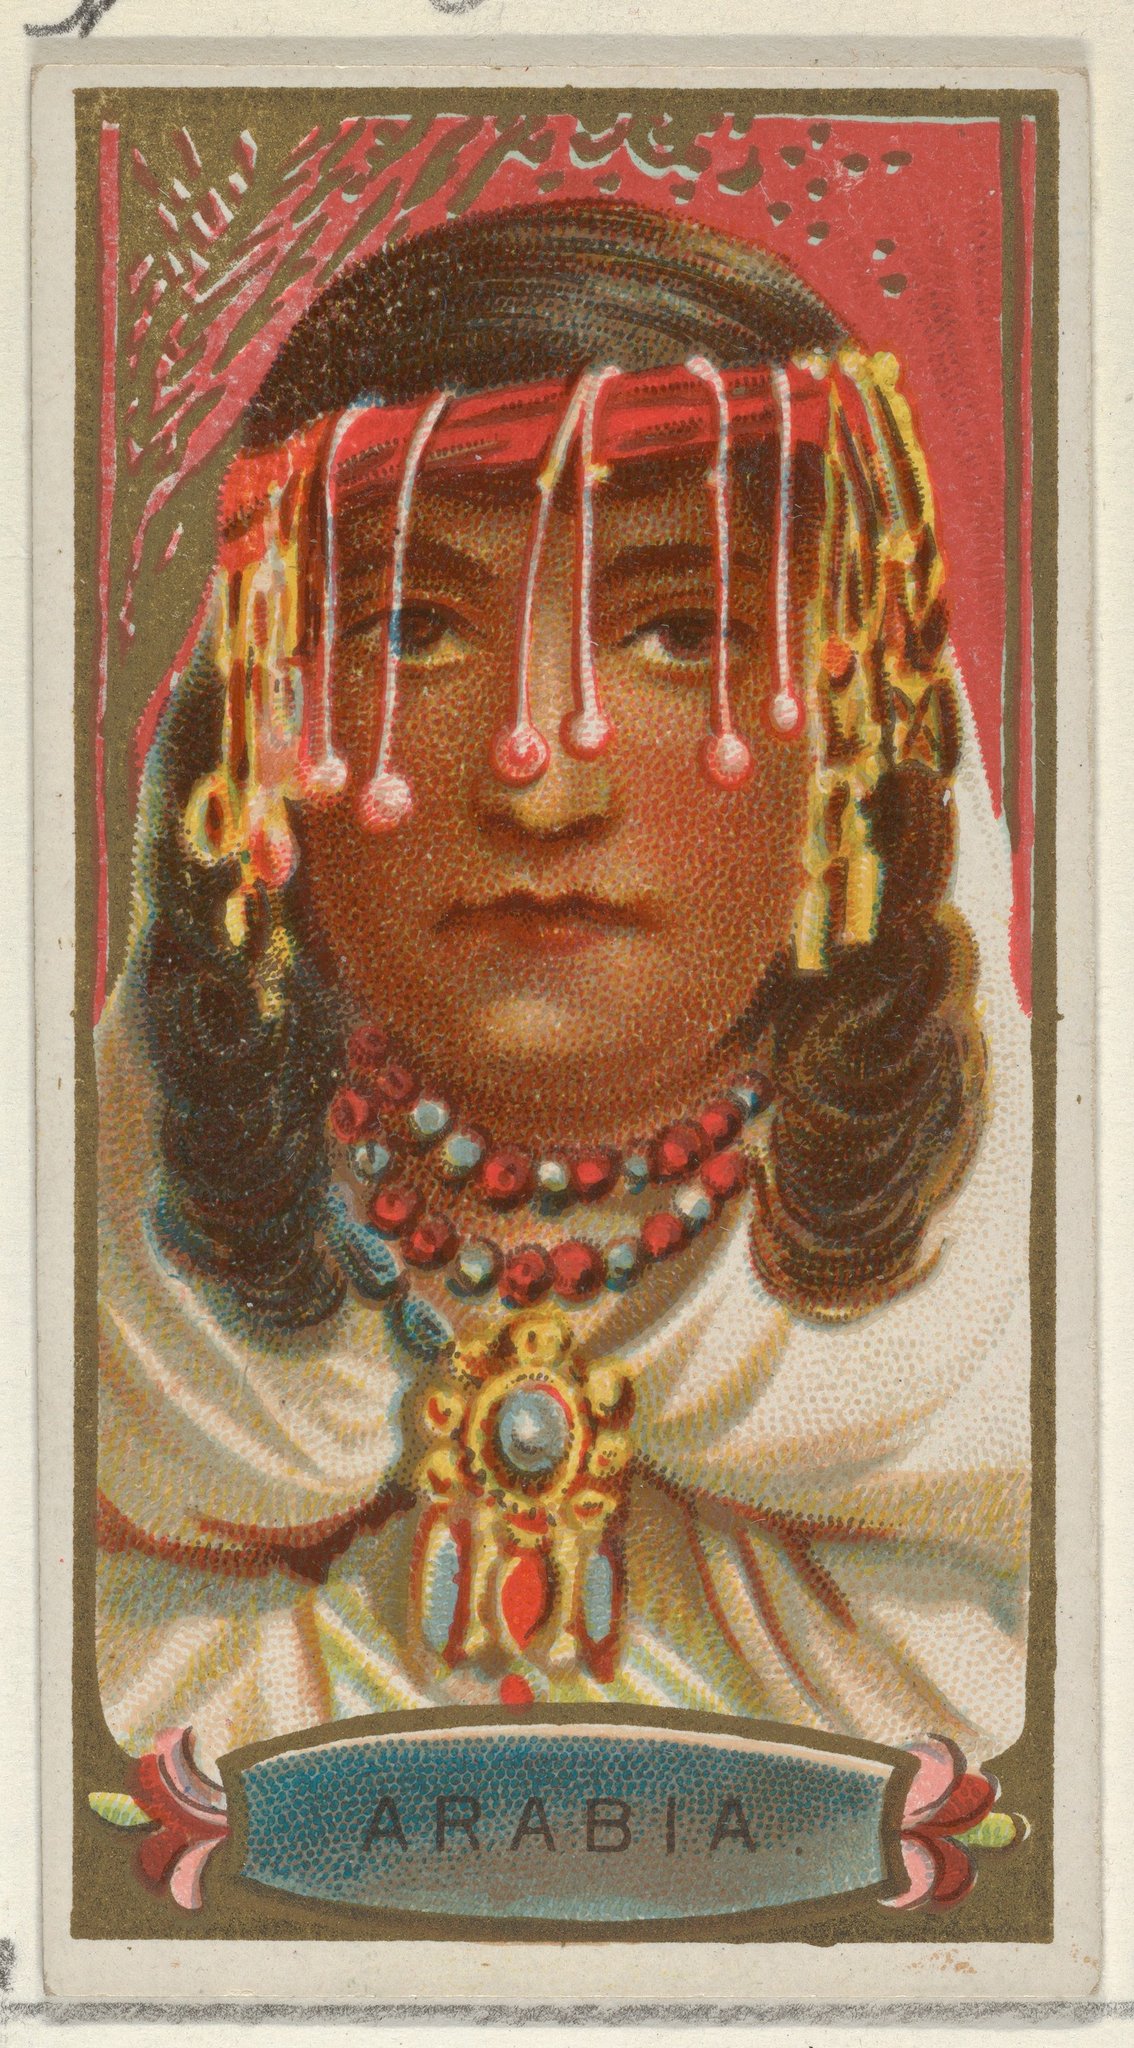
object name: print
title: Arabia, from the Types of All Nations series (N24) for Allen & Ginter Cigarettes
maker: allen & ginter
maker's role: publisher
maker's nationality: american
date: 1889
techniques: color lithograph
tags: women